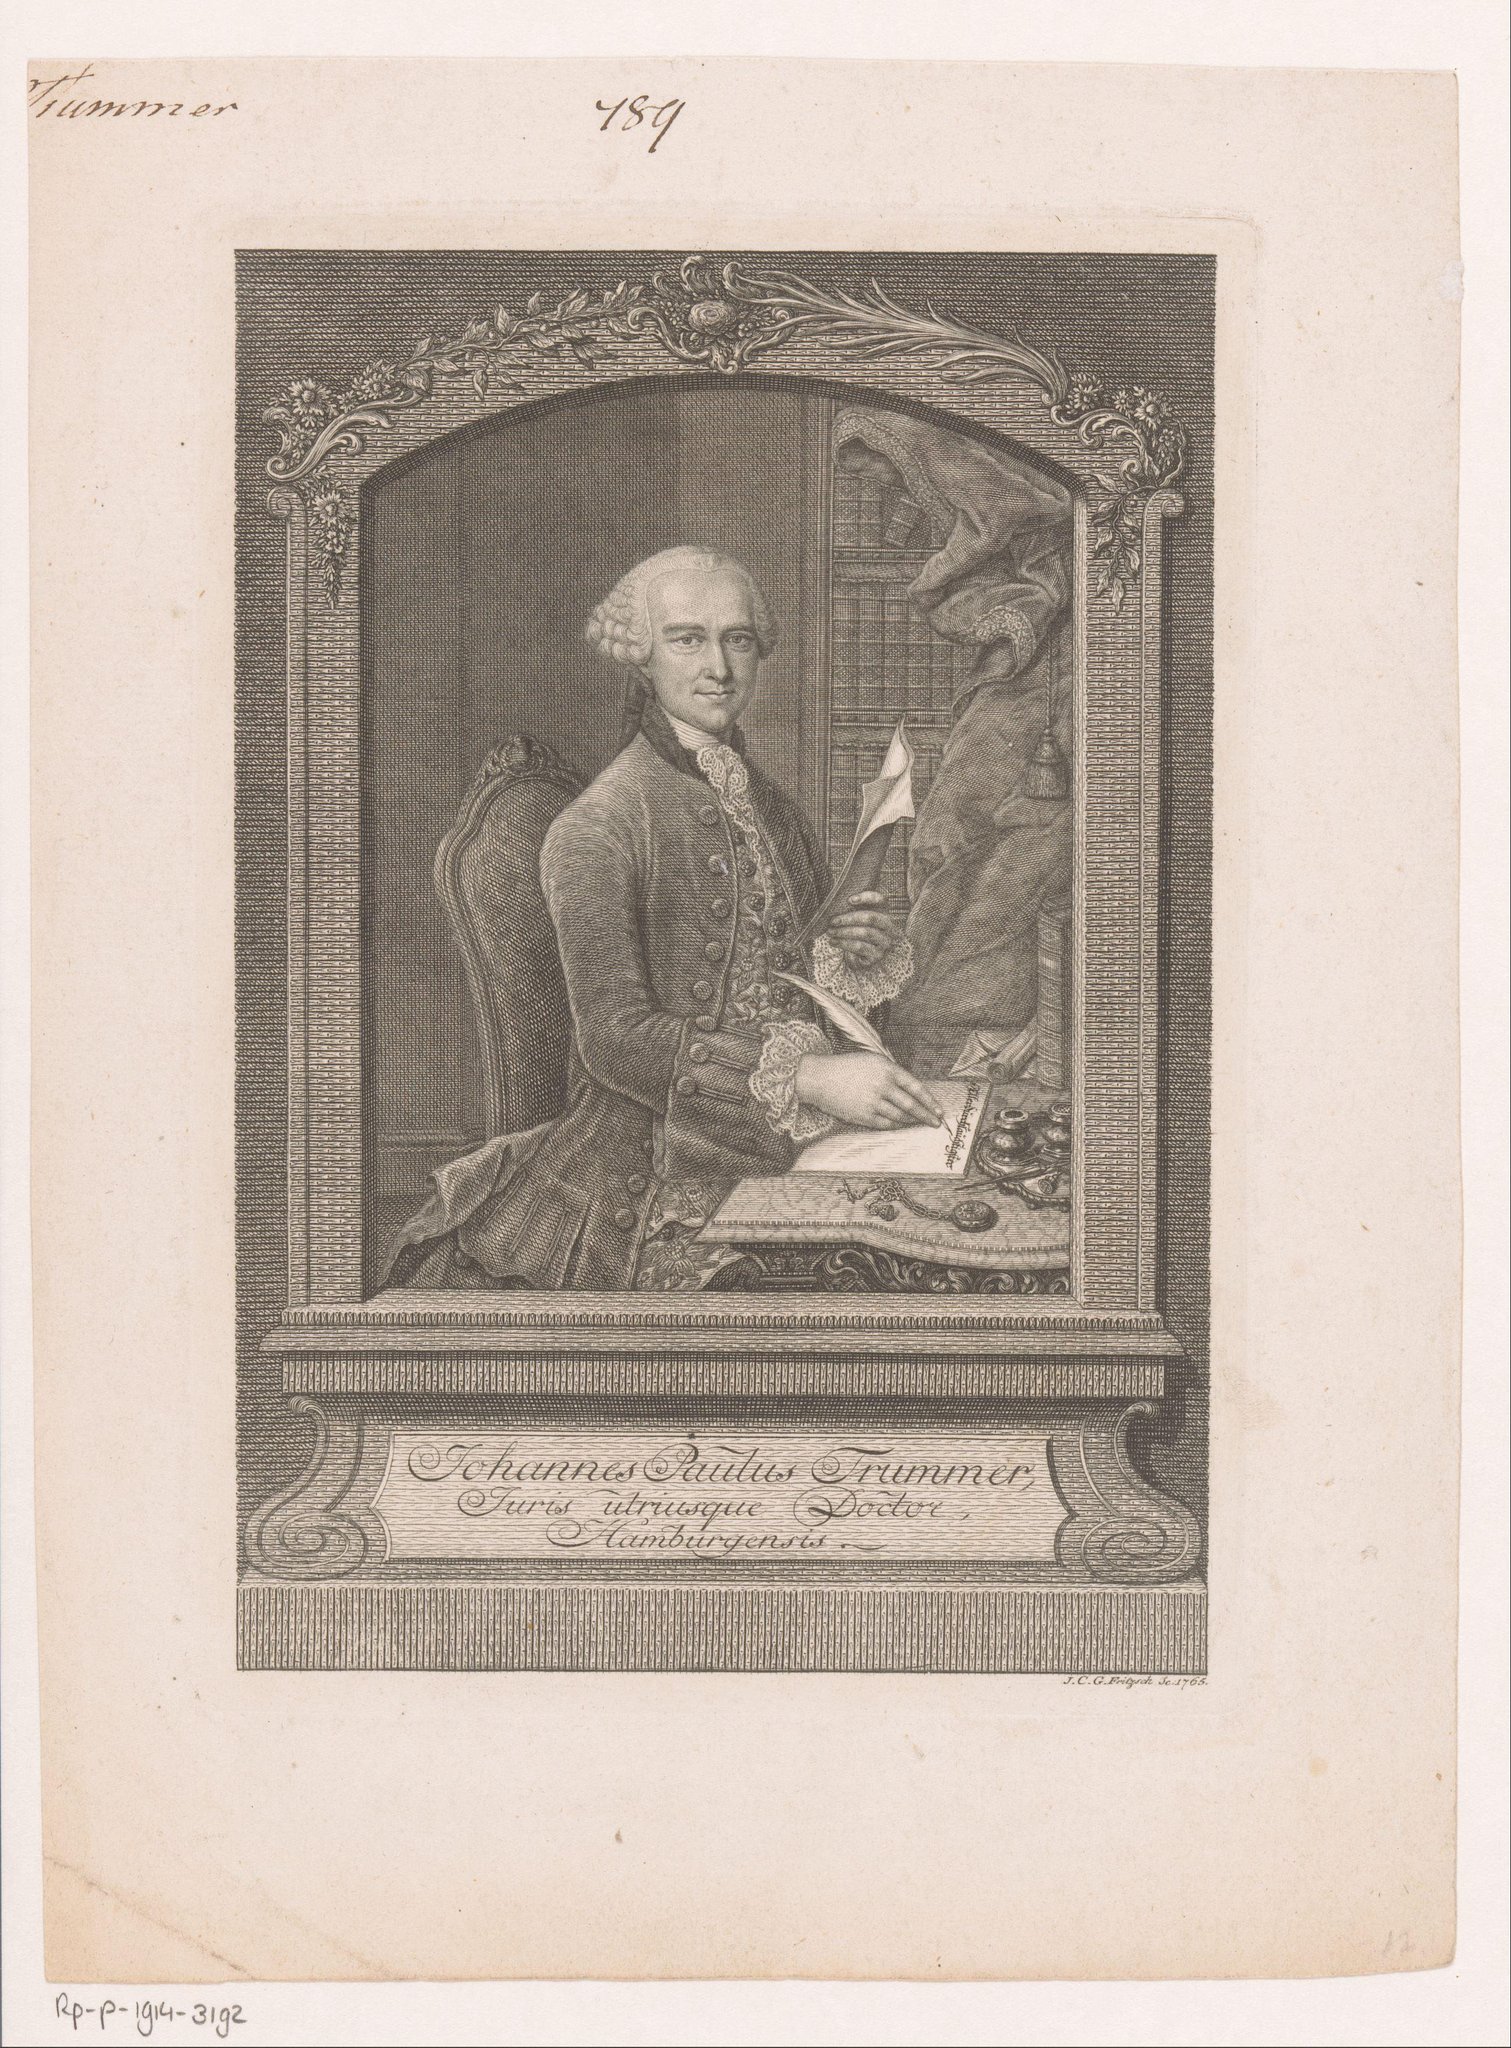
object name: print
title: Portret van Johann Paul Trummer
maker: johann christian gottfried fritzsch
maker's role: print maker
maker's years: 1720-1802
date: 1765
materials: paper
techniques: engraving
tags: bookshelves, trees: palm-tree (+ branch, stick), rocaille ornament, writing tools, historical persons, watch, trees: olive-tree (+ branch, stick)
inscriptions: collector's mark: Lugt 2228